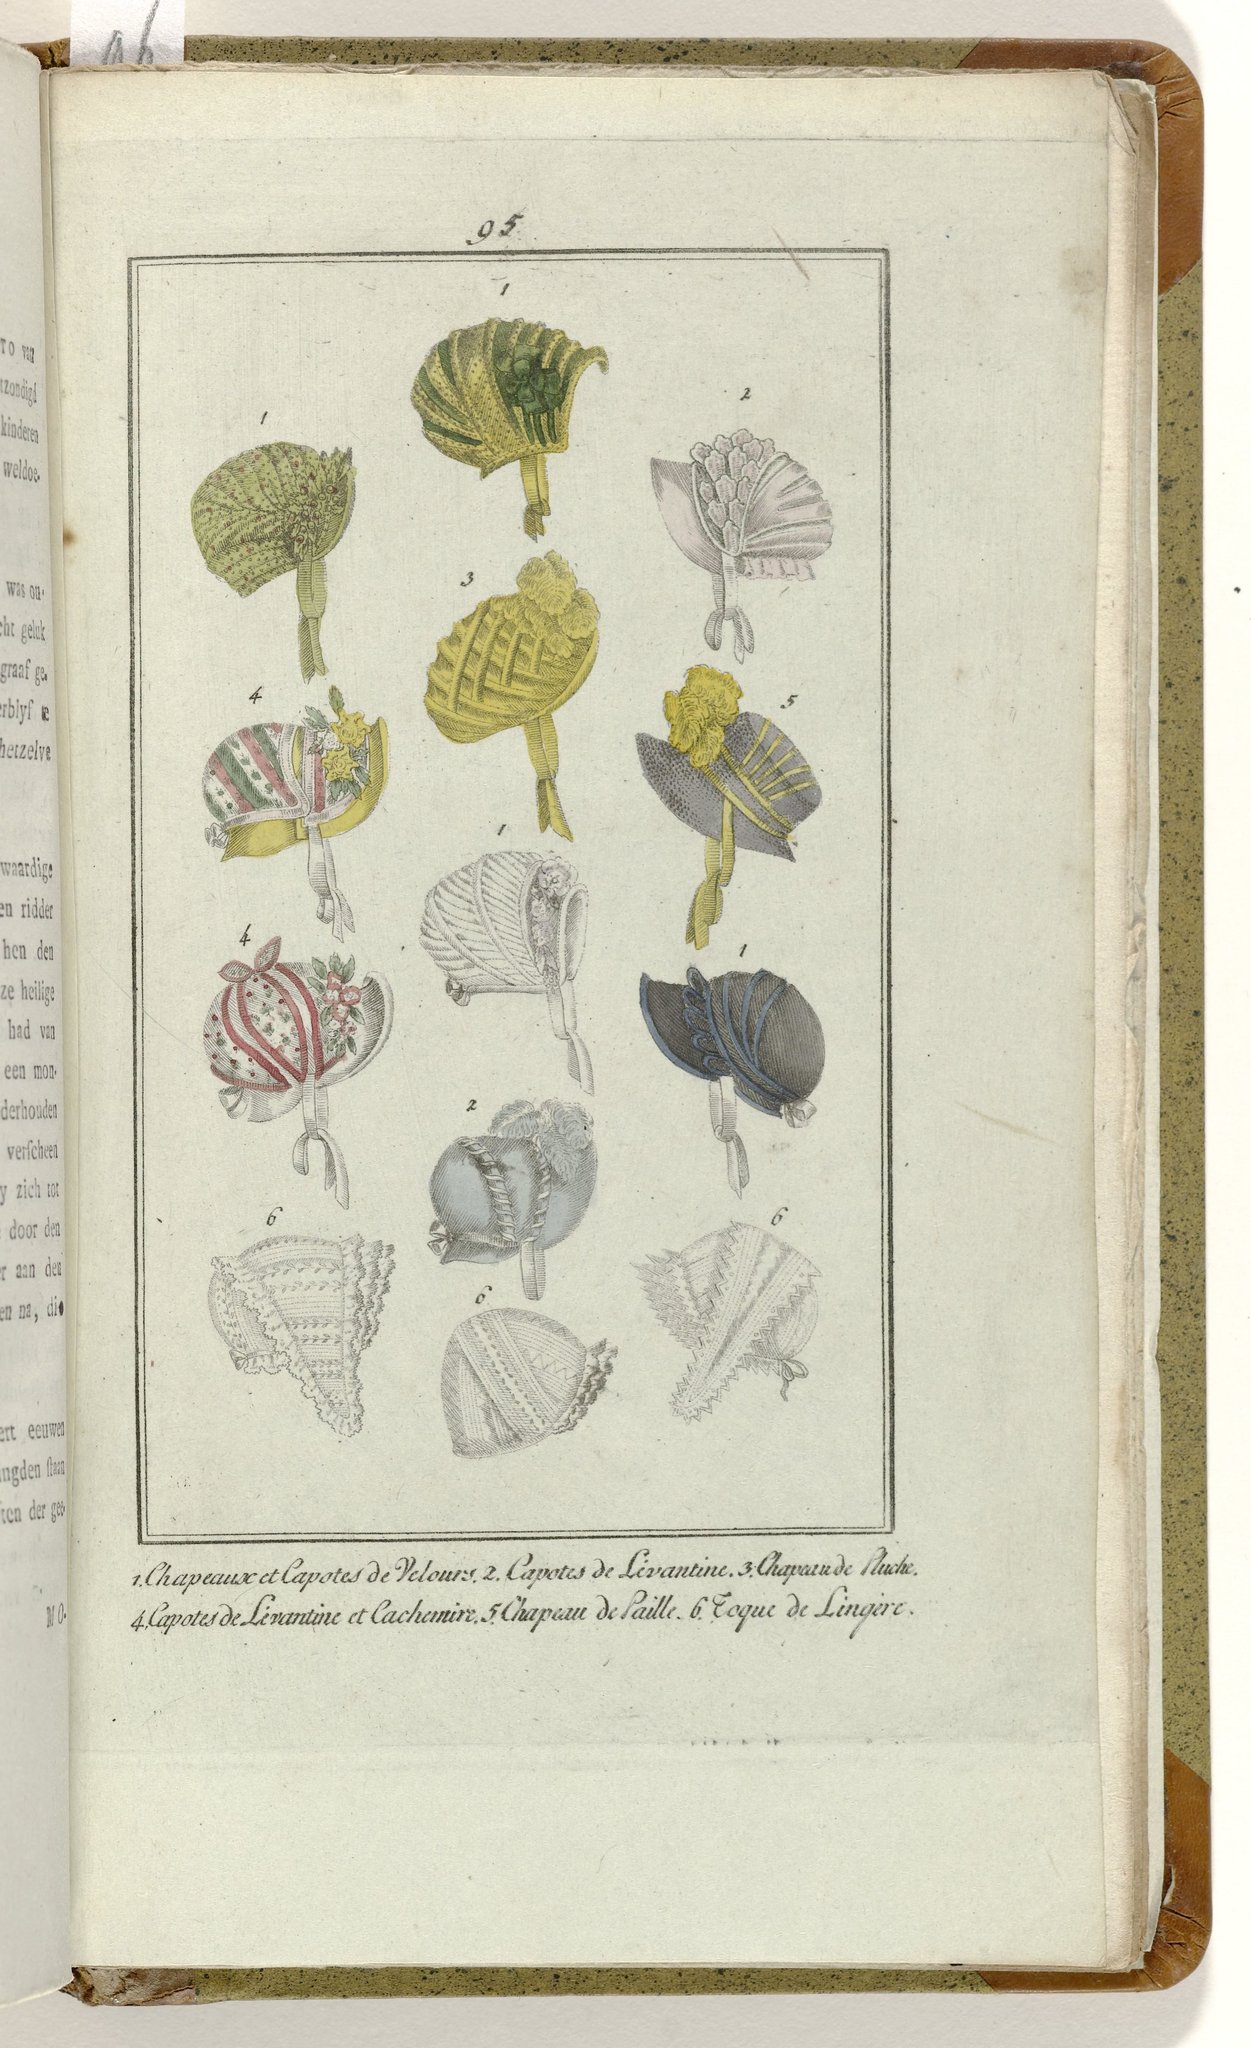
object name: fashion print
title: Elegantia, of tijdschrift van mode, luxe en smaak voor dames, December 1809, No. 95: Chapeaux et Capotes de Velours...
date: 1809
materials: paper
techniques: engraving, hand coloring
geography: amsterdam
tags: head-gear: toque (+ women's clothes), head-gear (capote) (+ women's clothes), head-gear (straw hat) (+ women's clothes), fashion plates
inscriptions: caption: ‘1. Chapeaux et Capotes de Velours, 2. Capotes de Lévantine. 3. Chapeau de Pluche. 4. Capotes de Lévantine et Cachemire. 5. Chapeau de Paille. 6. Toque de Lingére.’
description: Volgens de begeleidende tekst (p. 384): Dertien verschillende modellen van hoeden, capotes en toques, 'naar den nieuwsten Paryschen smaak'. Volgens het onderschrift: 1. Hoeden en capotes van fluweel. 2. Capotes van 'lévantine'. 3. Hoed van 'pluche'. 4. Capotes van 'Lévantine' en kasjmier. 5. Strohoed. 6. 'Toque de lingére'. Prent uit het modetijdschrift Elegantia, of tijdschrift van mode, luxe en smaak voor dames 1807-1814 (onderbroken door de periode 1811-1813).